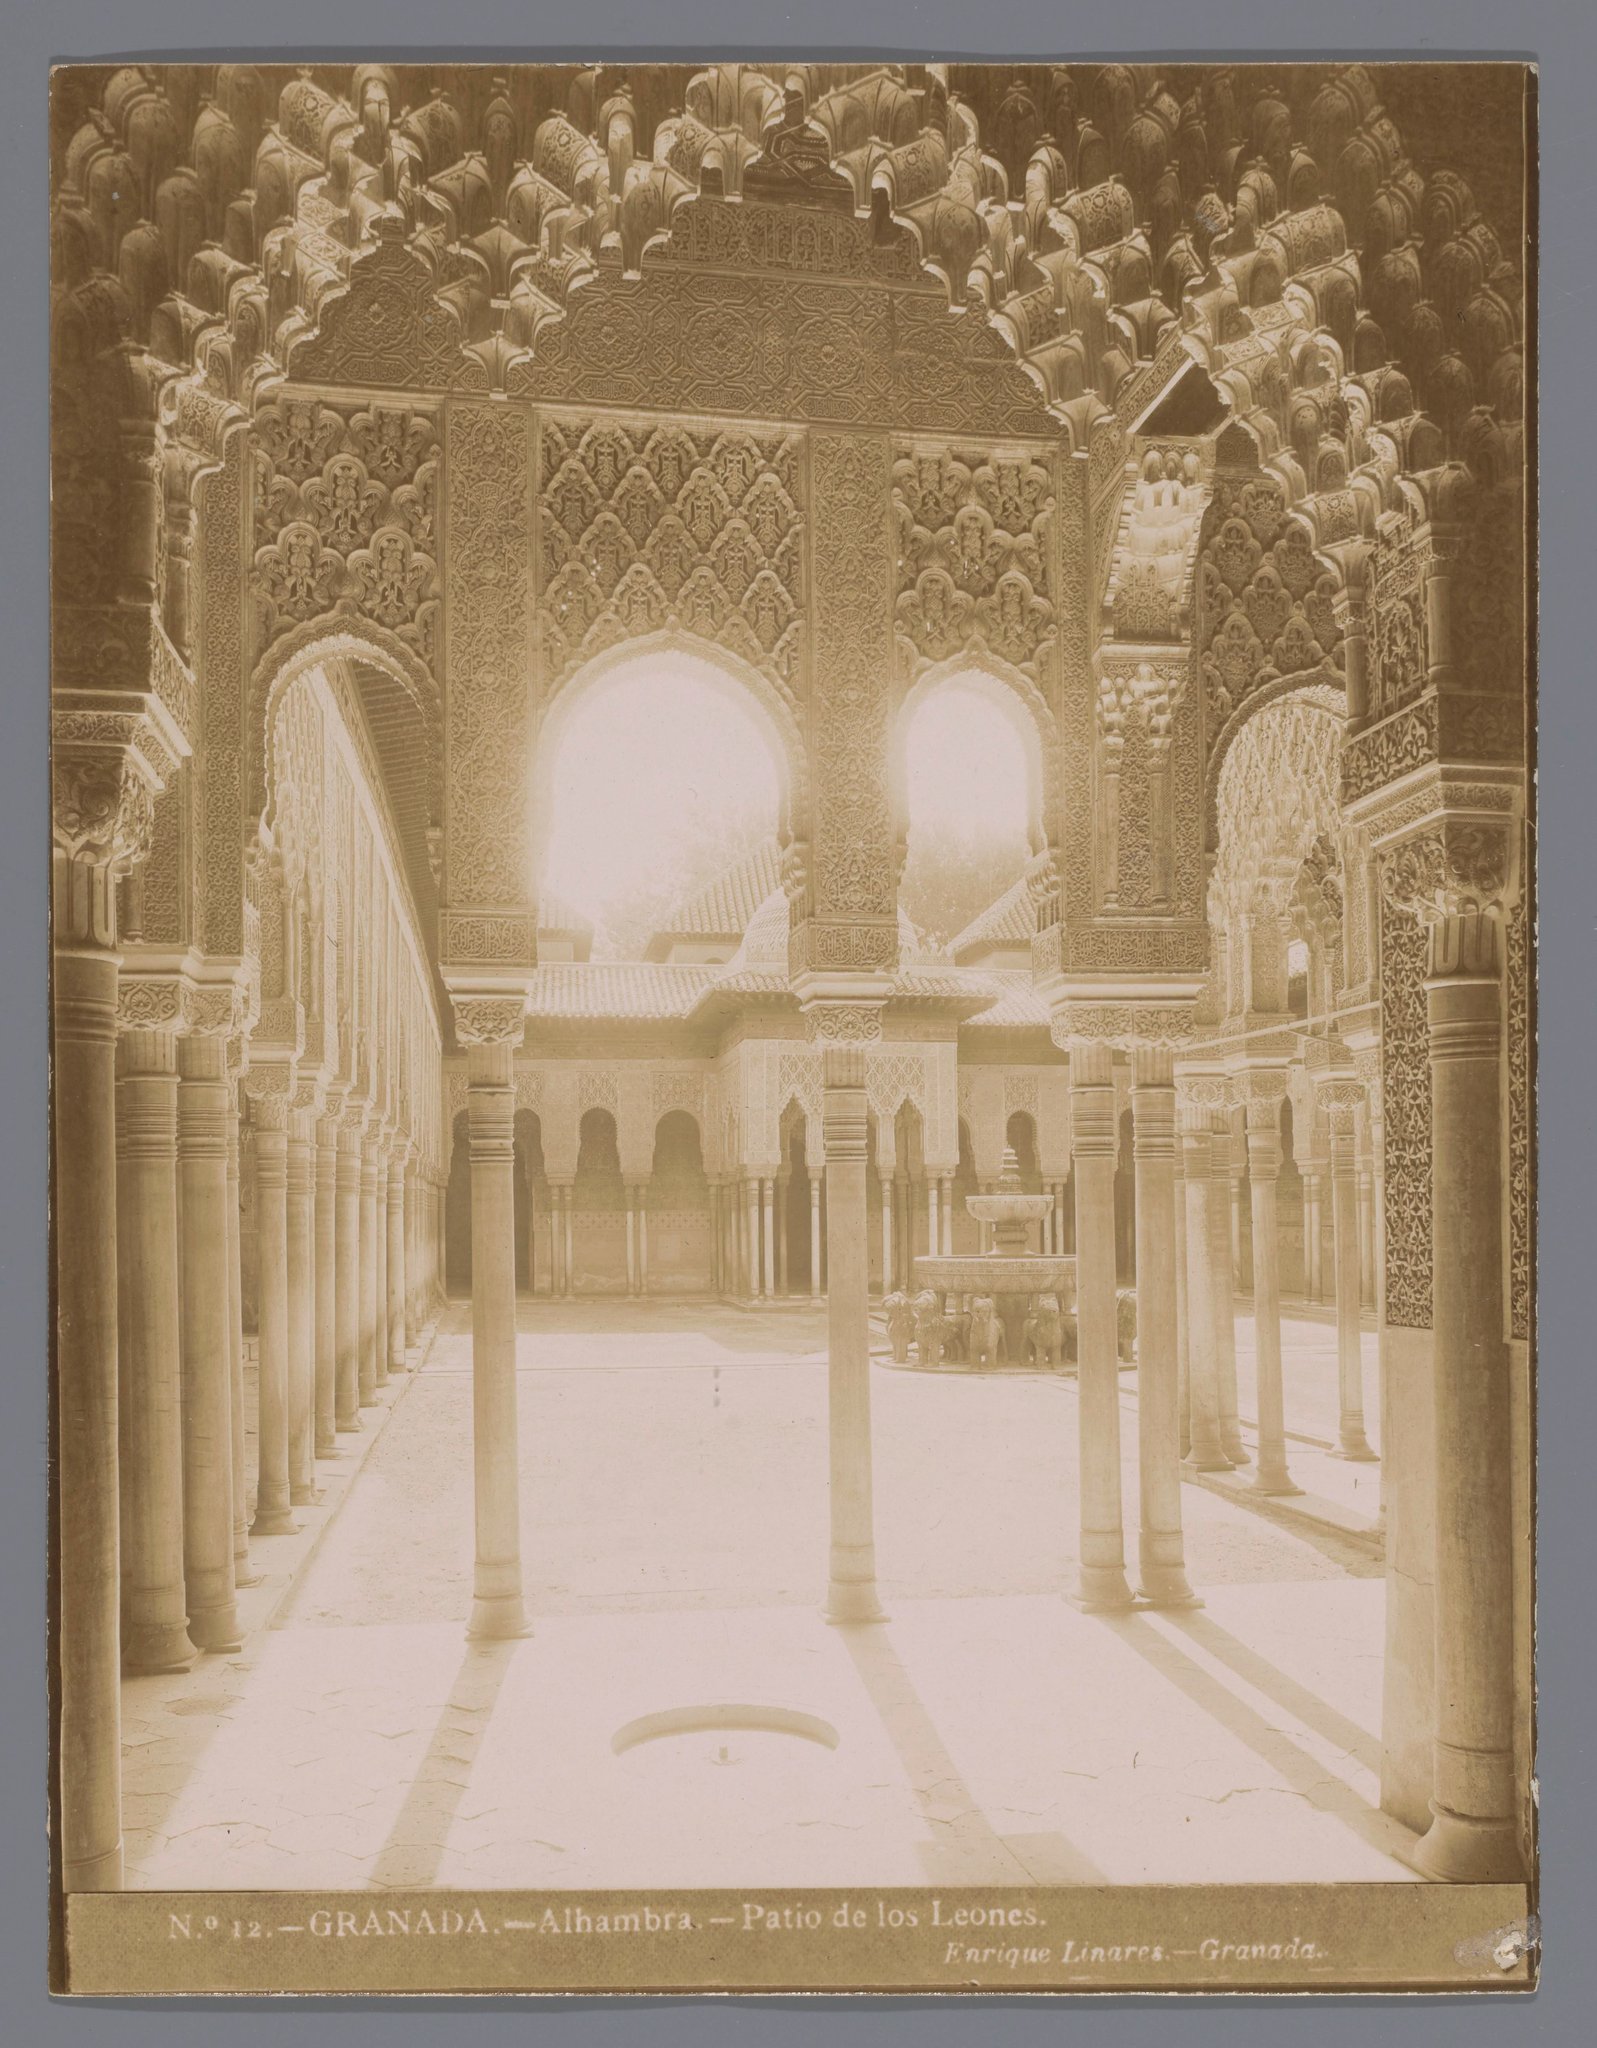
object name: photograph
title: Granada, Alhambra, Patio de los Leones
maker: enrique linares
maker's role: fotograaf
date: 1900-1930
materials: paper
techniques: gelatin silver print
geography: granada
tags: courtyard, ornamental fountain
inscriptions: number: ‘No 12.’